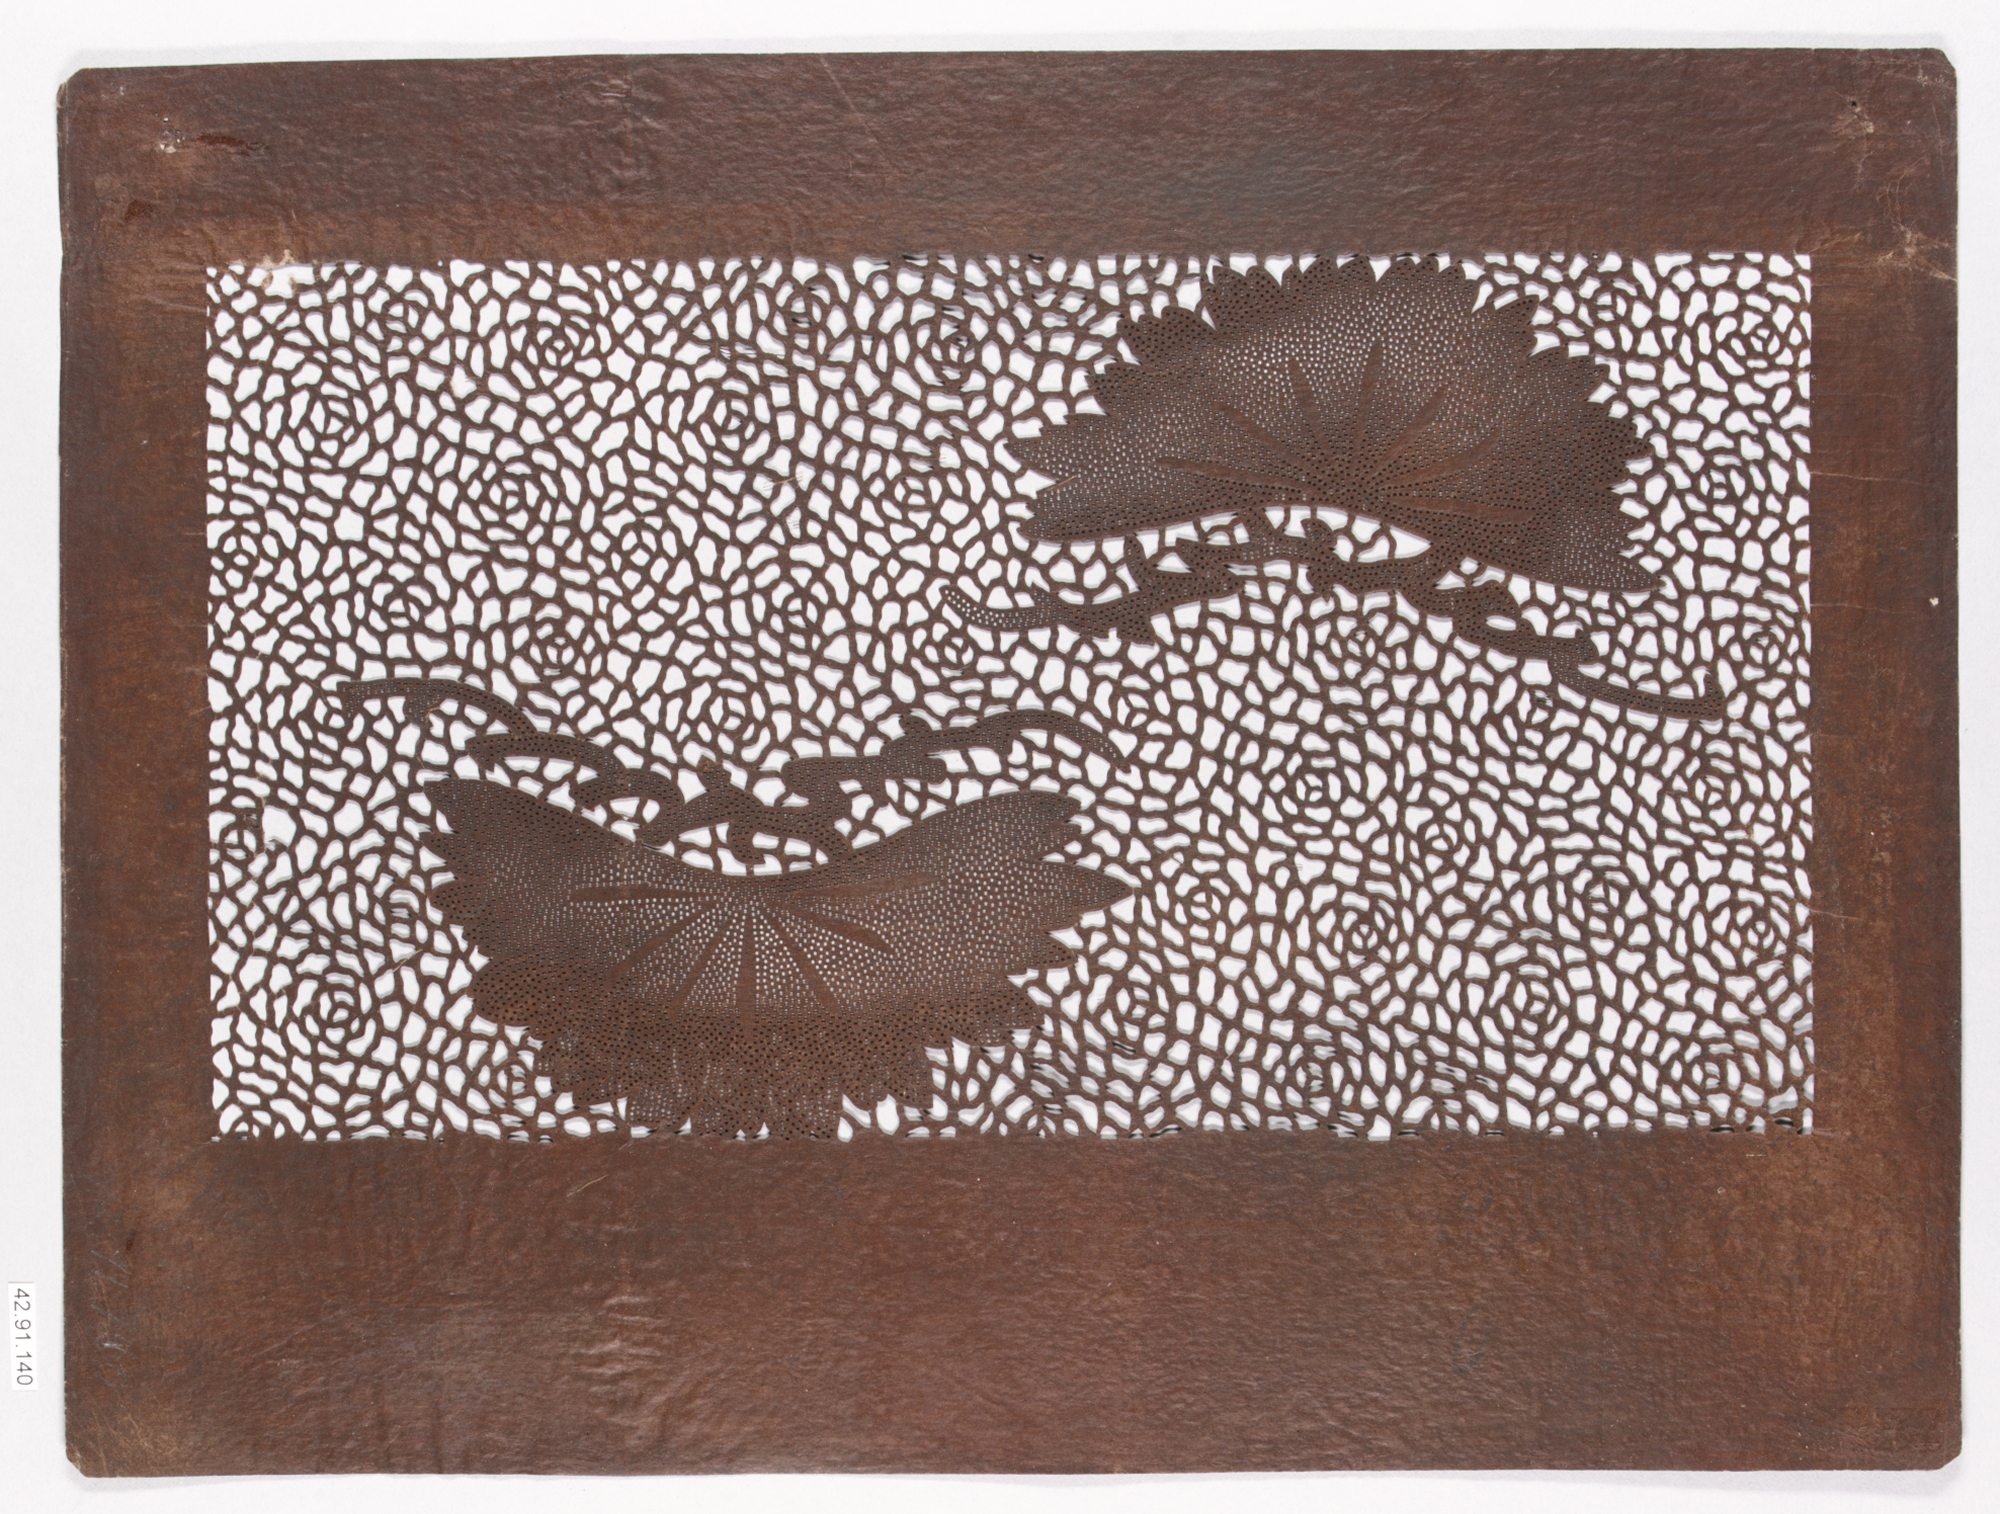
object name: stencil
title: Stencil with Pines and a Background of Peony Flowers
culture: japanese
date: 1801-1900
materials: paper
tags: peonies